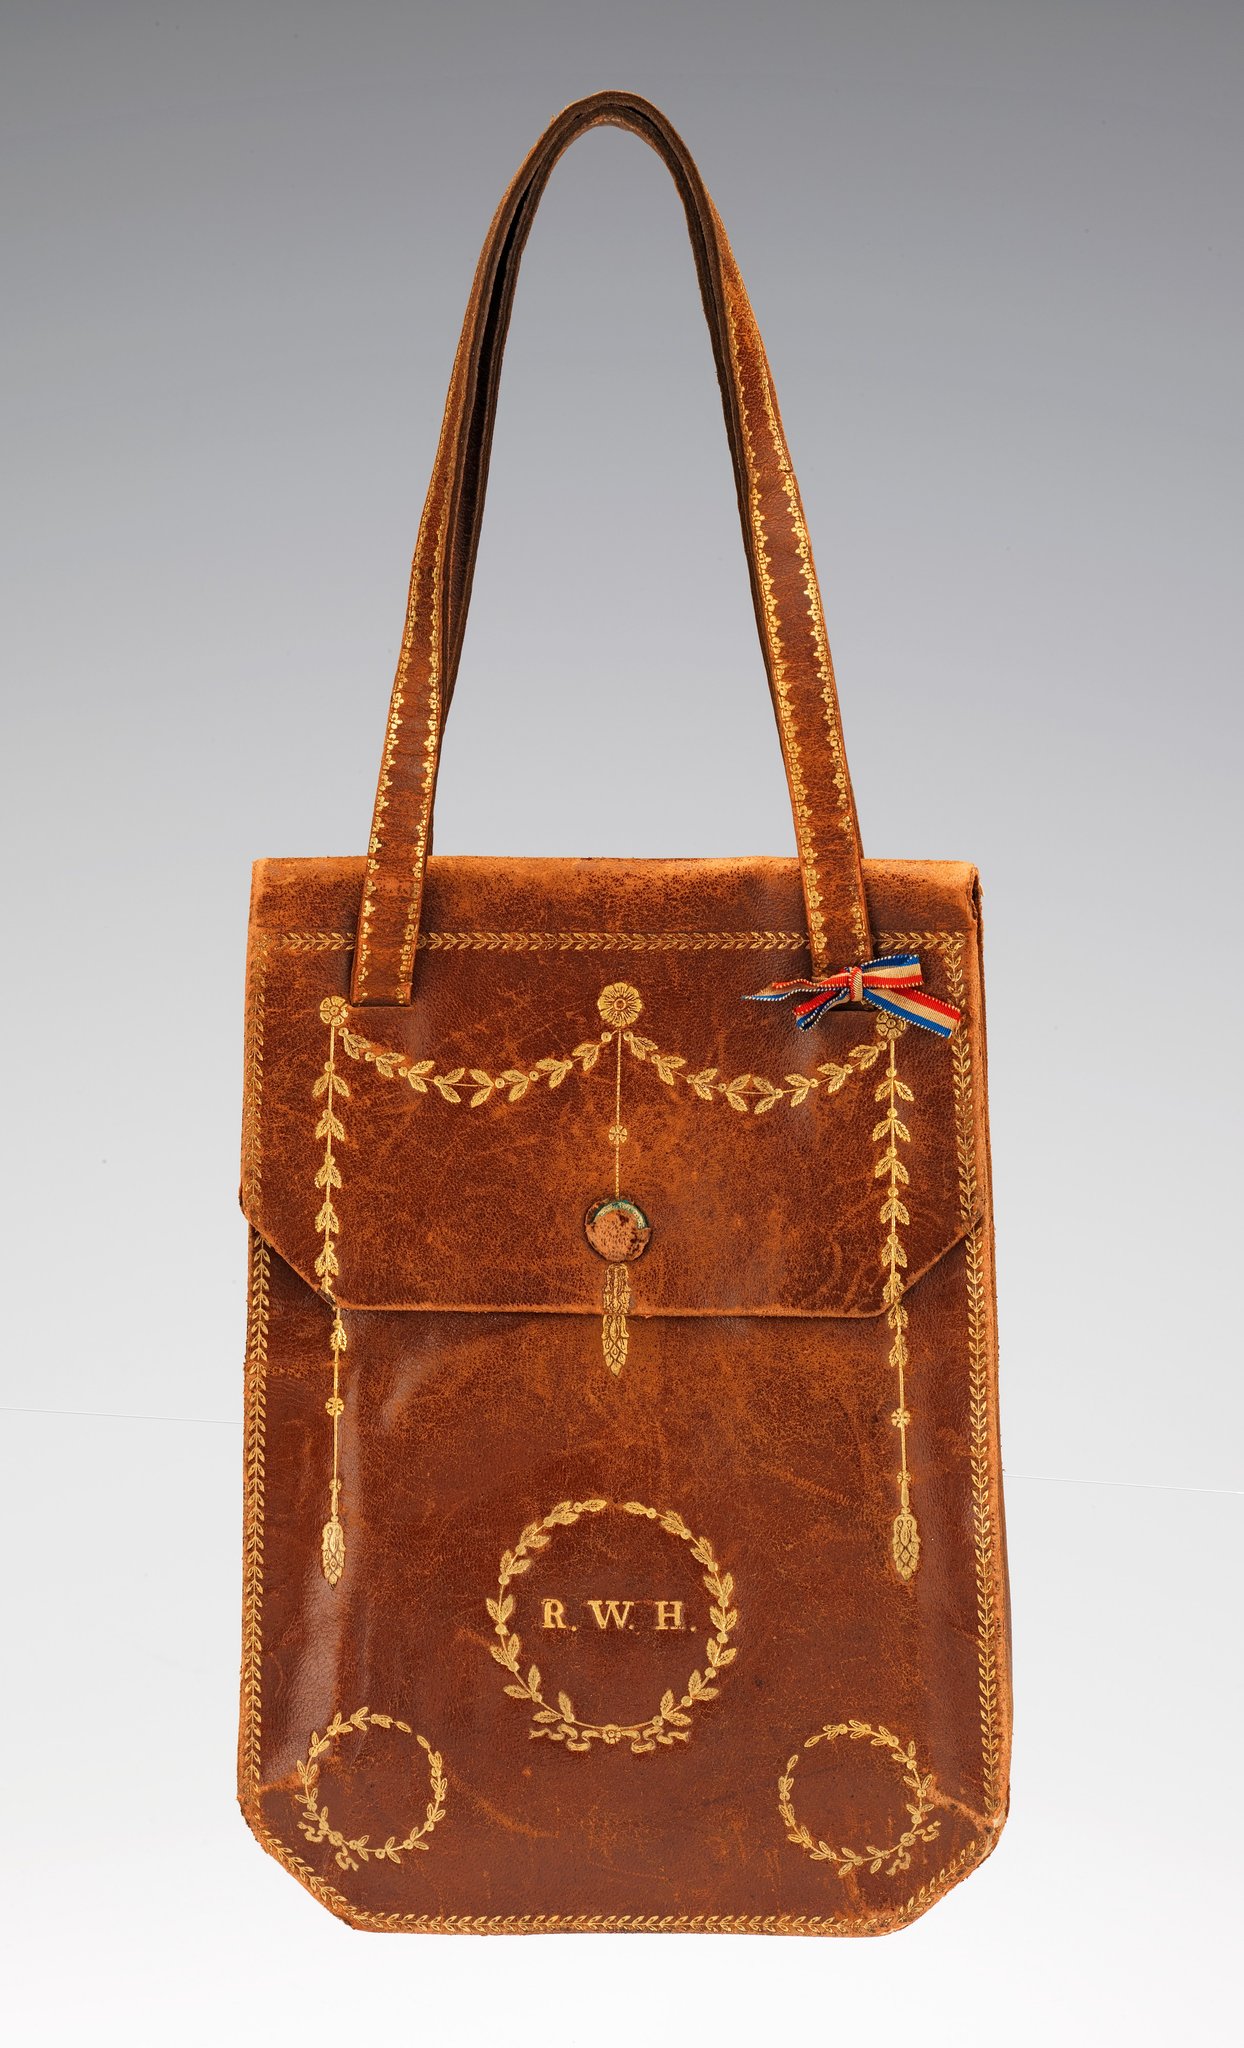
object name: bag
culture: italian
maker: a. antinori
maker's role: department store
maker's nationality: italian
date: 1801-1825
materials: leather